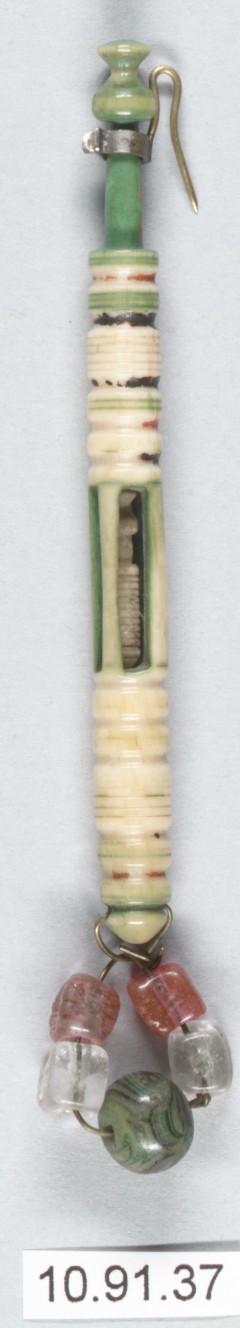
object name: bobbin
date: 1801-1900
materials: bone